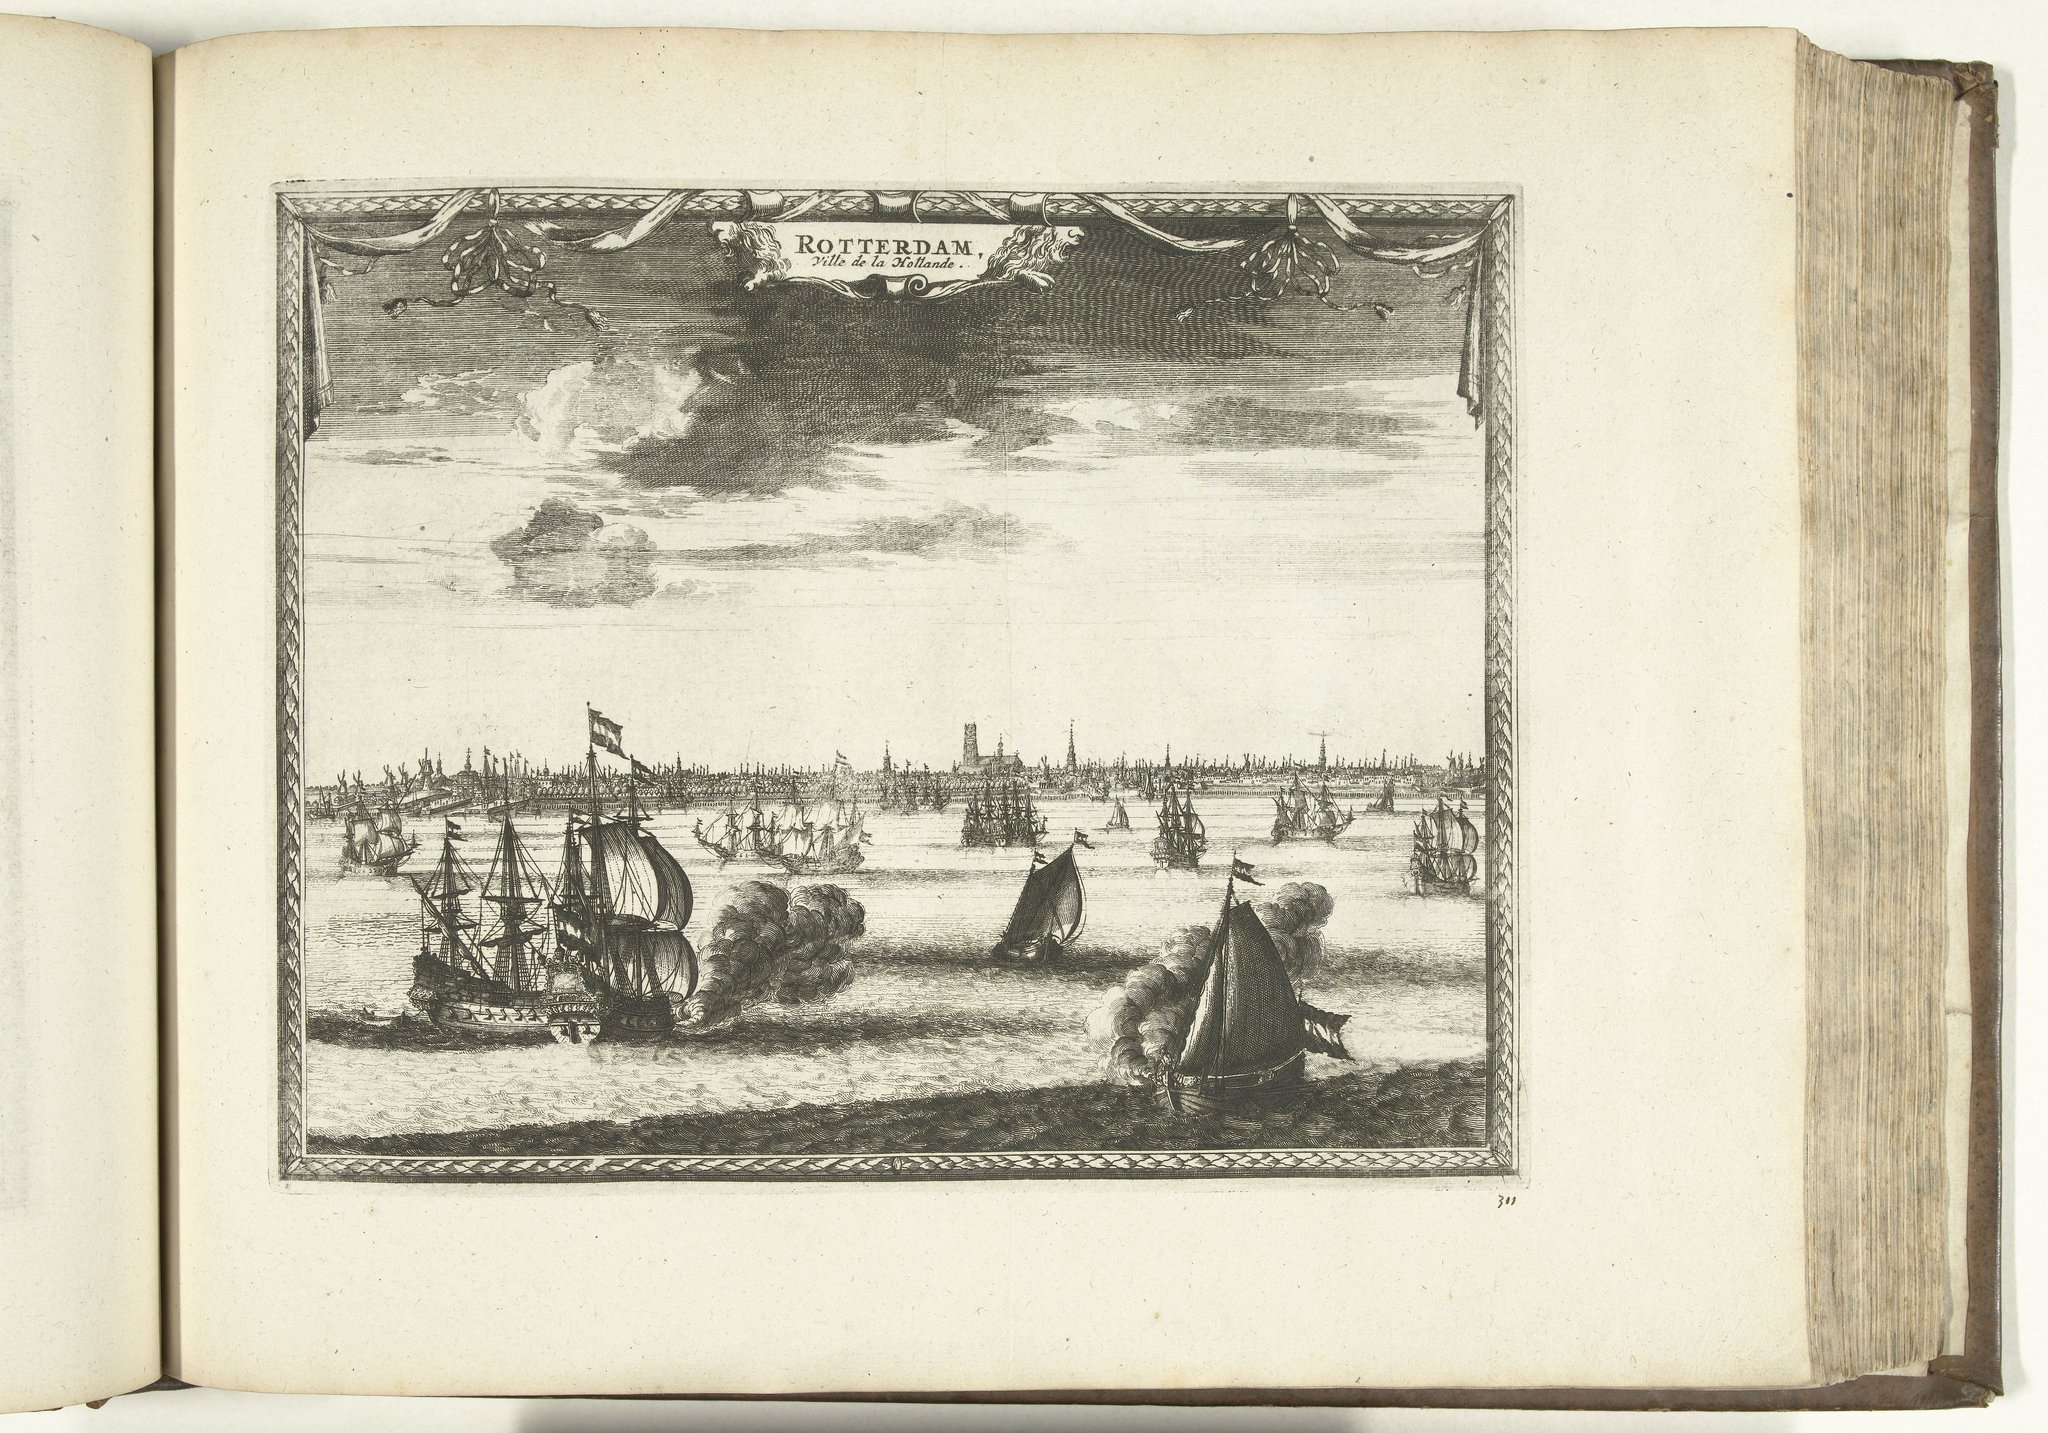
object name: print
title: Gezicht op Rotterdam, 1726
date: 1726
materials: paper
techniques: etching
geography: northern netherlands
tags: rotterdam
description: Gezicht op Rotterdam, op de voorgrond enkele vurende schepen. Plaat nr. 311 in deel XIII van het prentwerk: Les Forces de l'Europe, Asie, Afrique et Amerique ... Comme aussi les Cartes des Côtes de France et d'Espagne uit 1726, dit tweede deel met 271 met de hand genummerde platen van vermaarde sterke steden en vestingen in het kader van de Spaanse Successieoorlog 1701-1713. Voor het merendeel zijn deze platen gekopieerd naar de anonieme Franse platen van vermaarde sterke steden en vestingen: in Les forces de l'Europe en in: Le theatre de la guerre, dans les Pays-Bas, beide oorspronkelijk uitgegeven door Nicolas de Fer te Parijs (1693-1697) in het kader van de Negenjarige Oorlog. Titel in het Frans.